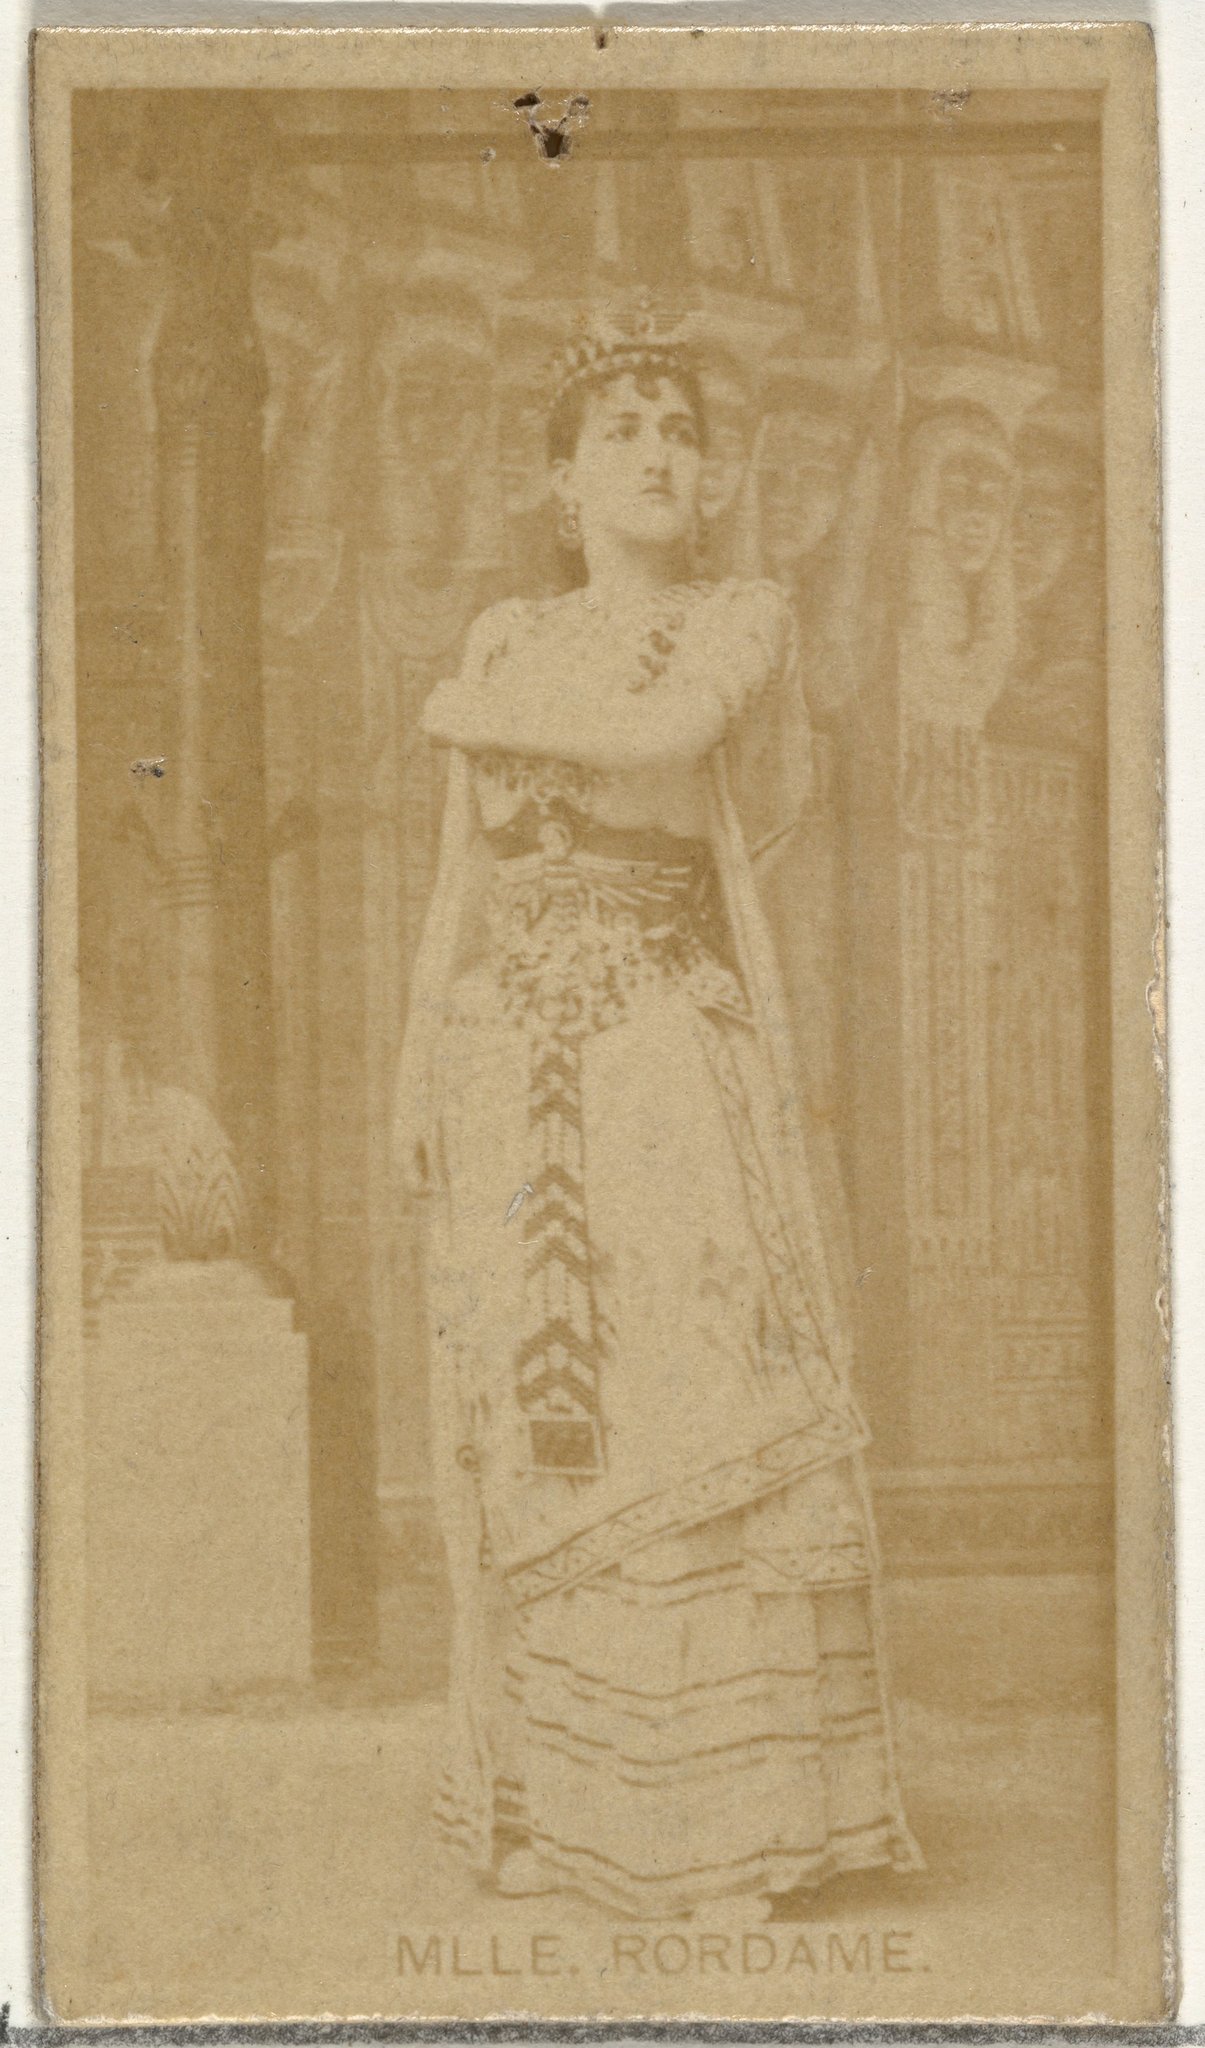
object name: photograph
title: Mlle. Rordame, from the Actors and Actresses series (N145-8) issued by Duke Sons & Co. to promote Duke Cigarettes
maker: w. duke, sons & co.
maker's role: publisher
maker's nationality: american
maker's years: 1870-1920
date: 1891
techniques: albumen silver print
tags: portraits,women,actresses